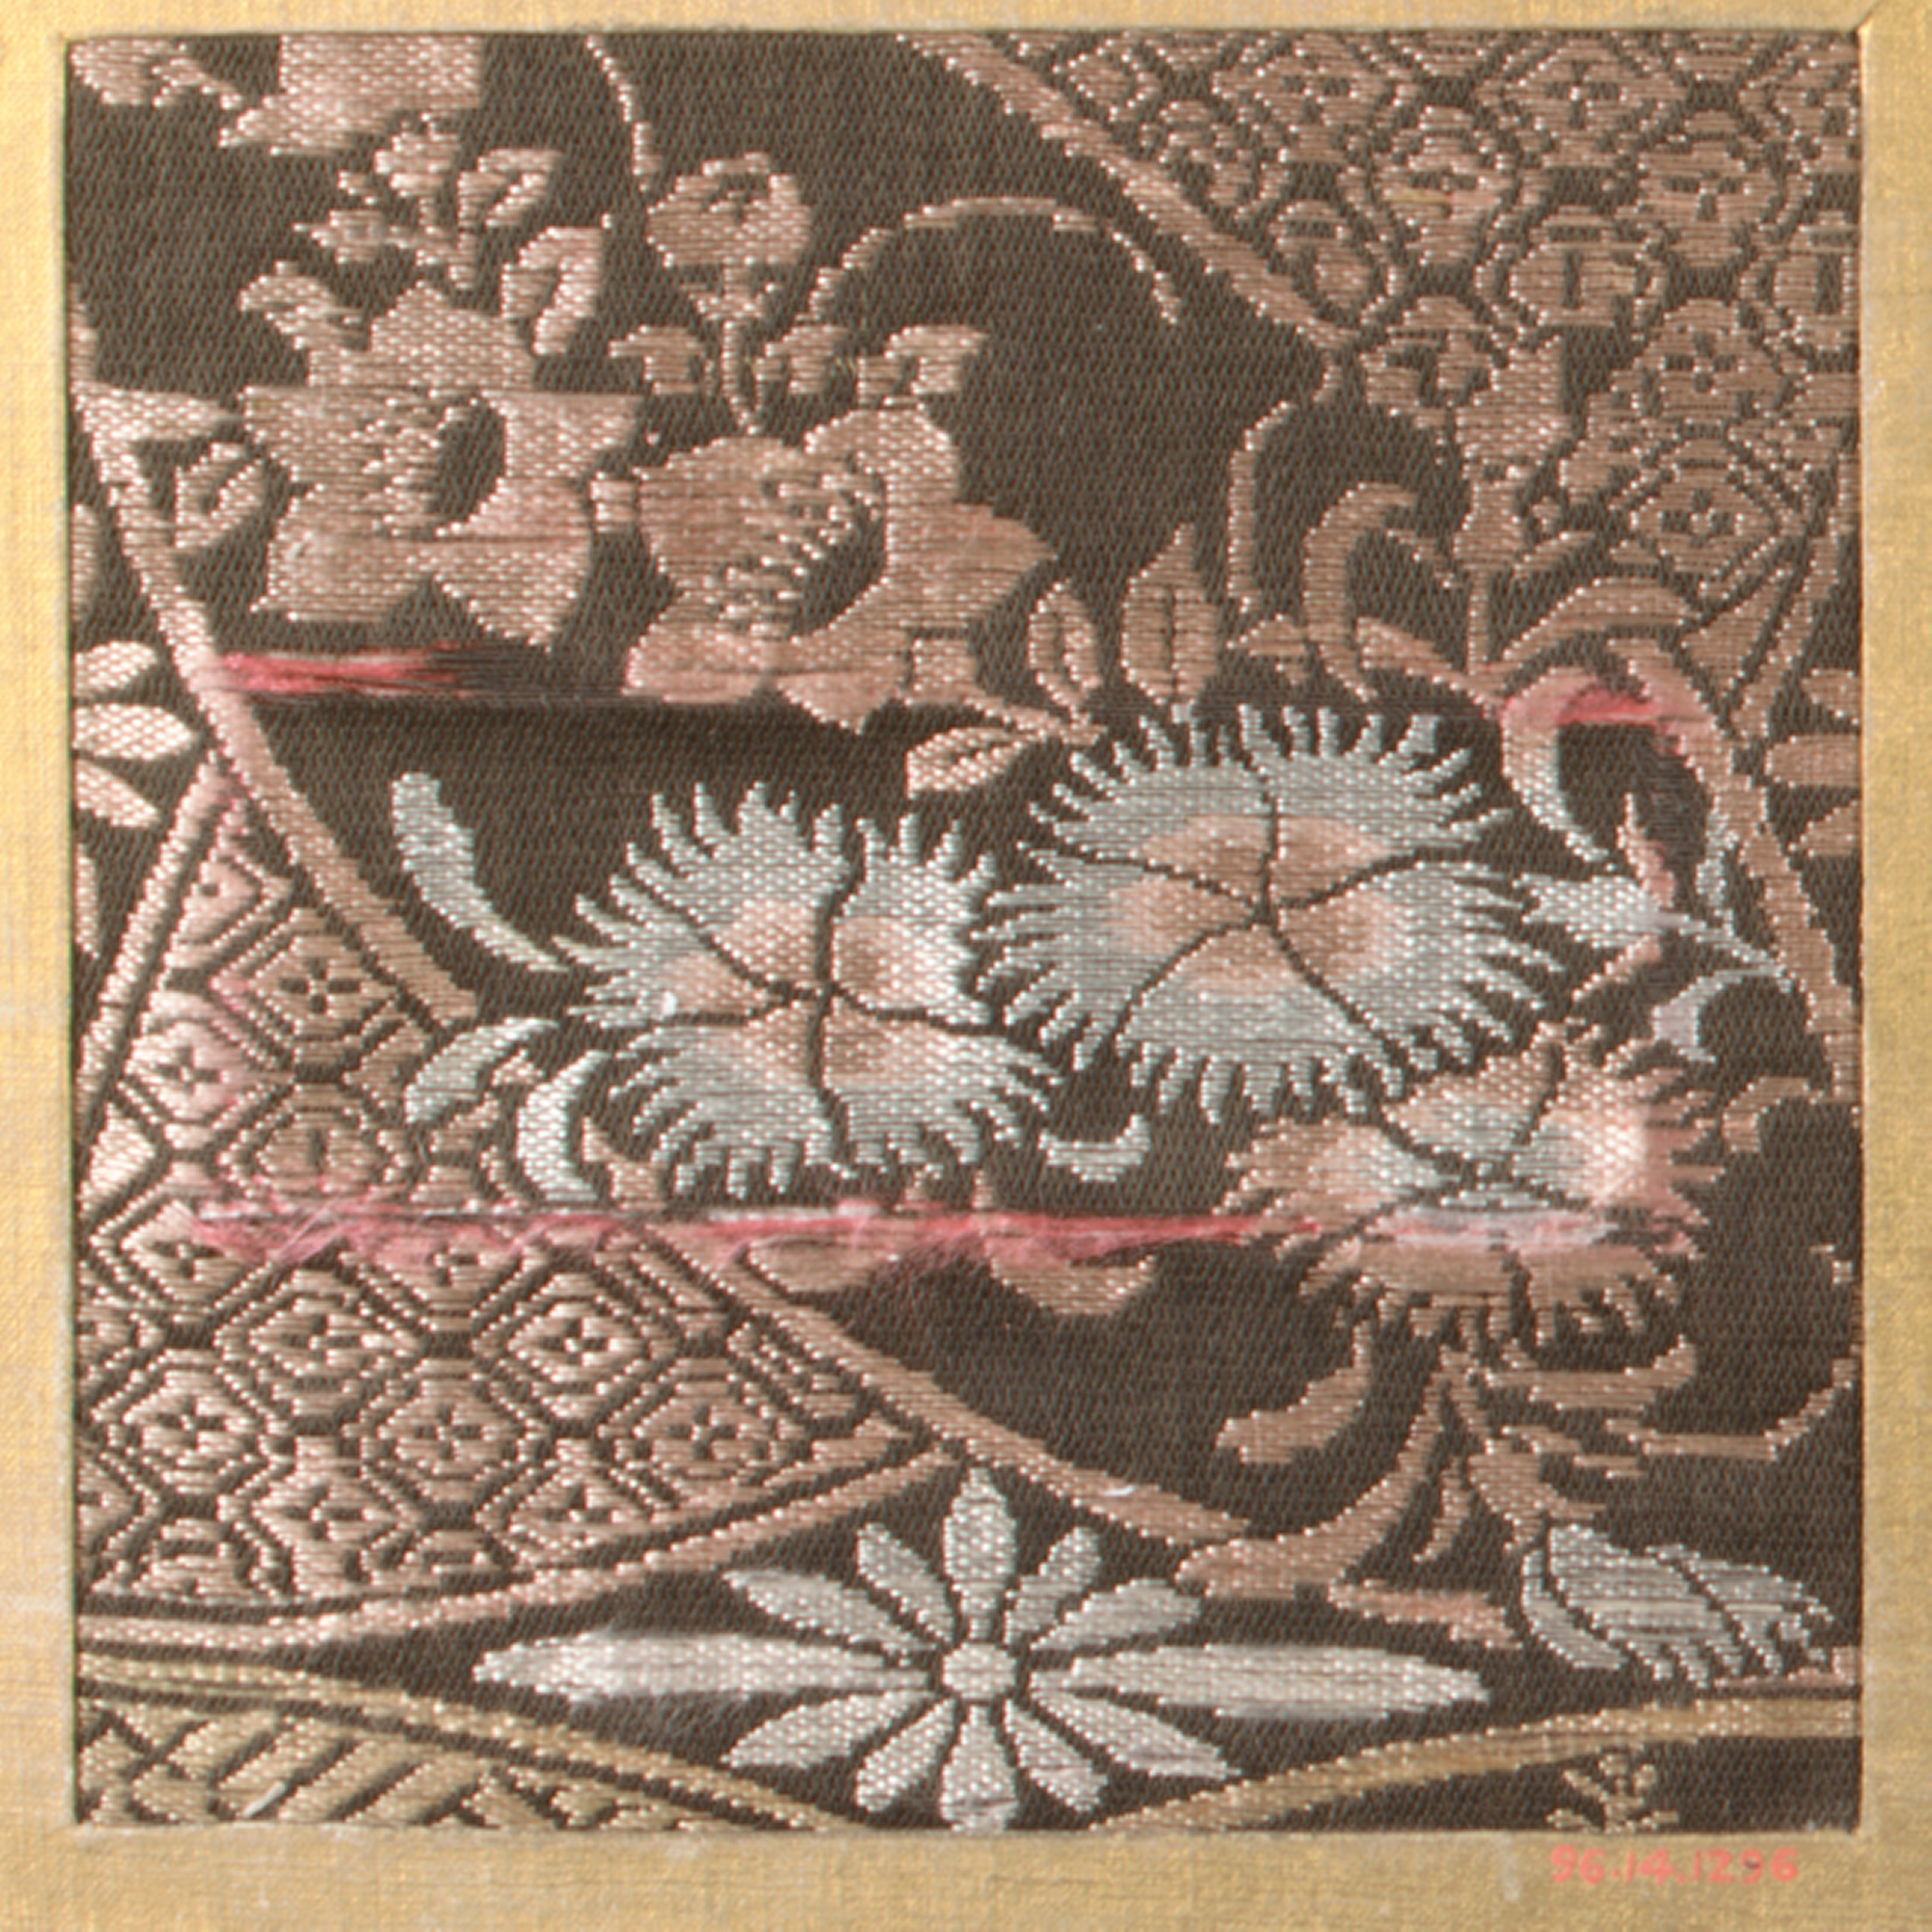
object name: piece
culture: japanese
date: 1701-1900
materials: silk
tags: flowers